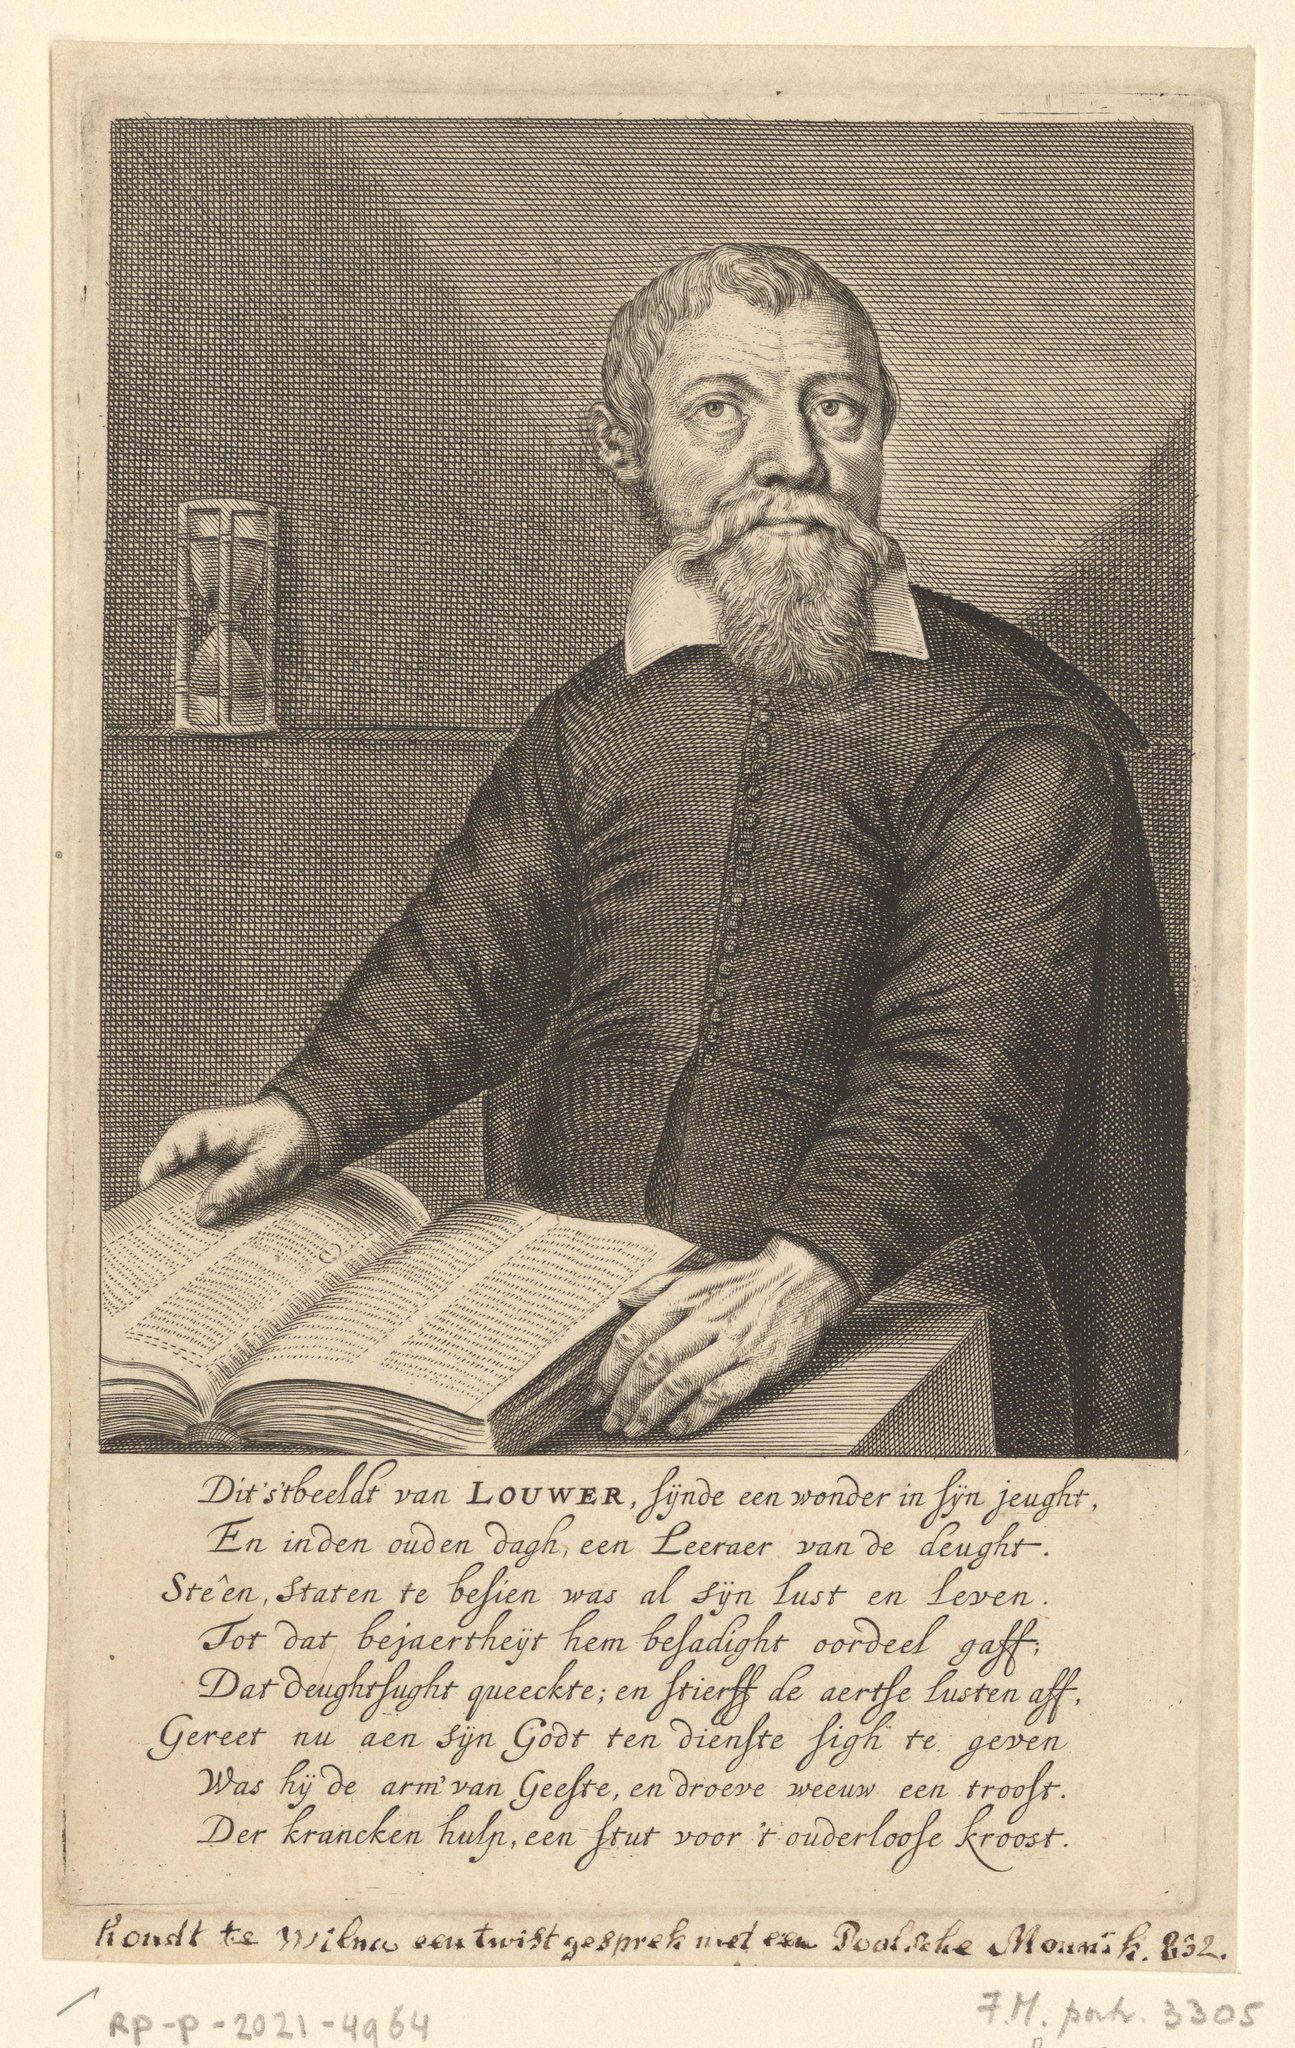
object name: print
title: Portret van Bartel Louwer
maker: Anonymous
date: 1650-1700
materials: paper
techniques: engraving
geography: northern netherlands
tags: historical persons, book - mm - book open, hourglass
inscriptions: inscription: ‘houdt te Wilna een twistgesprek met een Poolsche Monnik. 832.’, collector's mark: Lugt 2228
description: Met achtregelig vers in het Nederlands onder het portret.